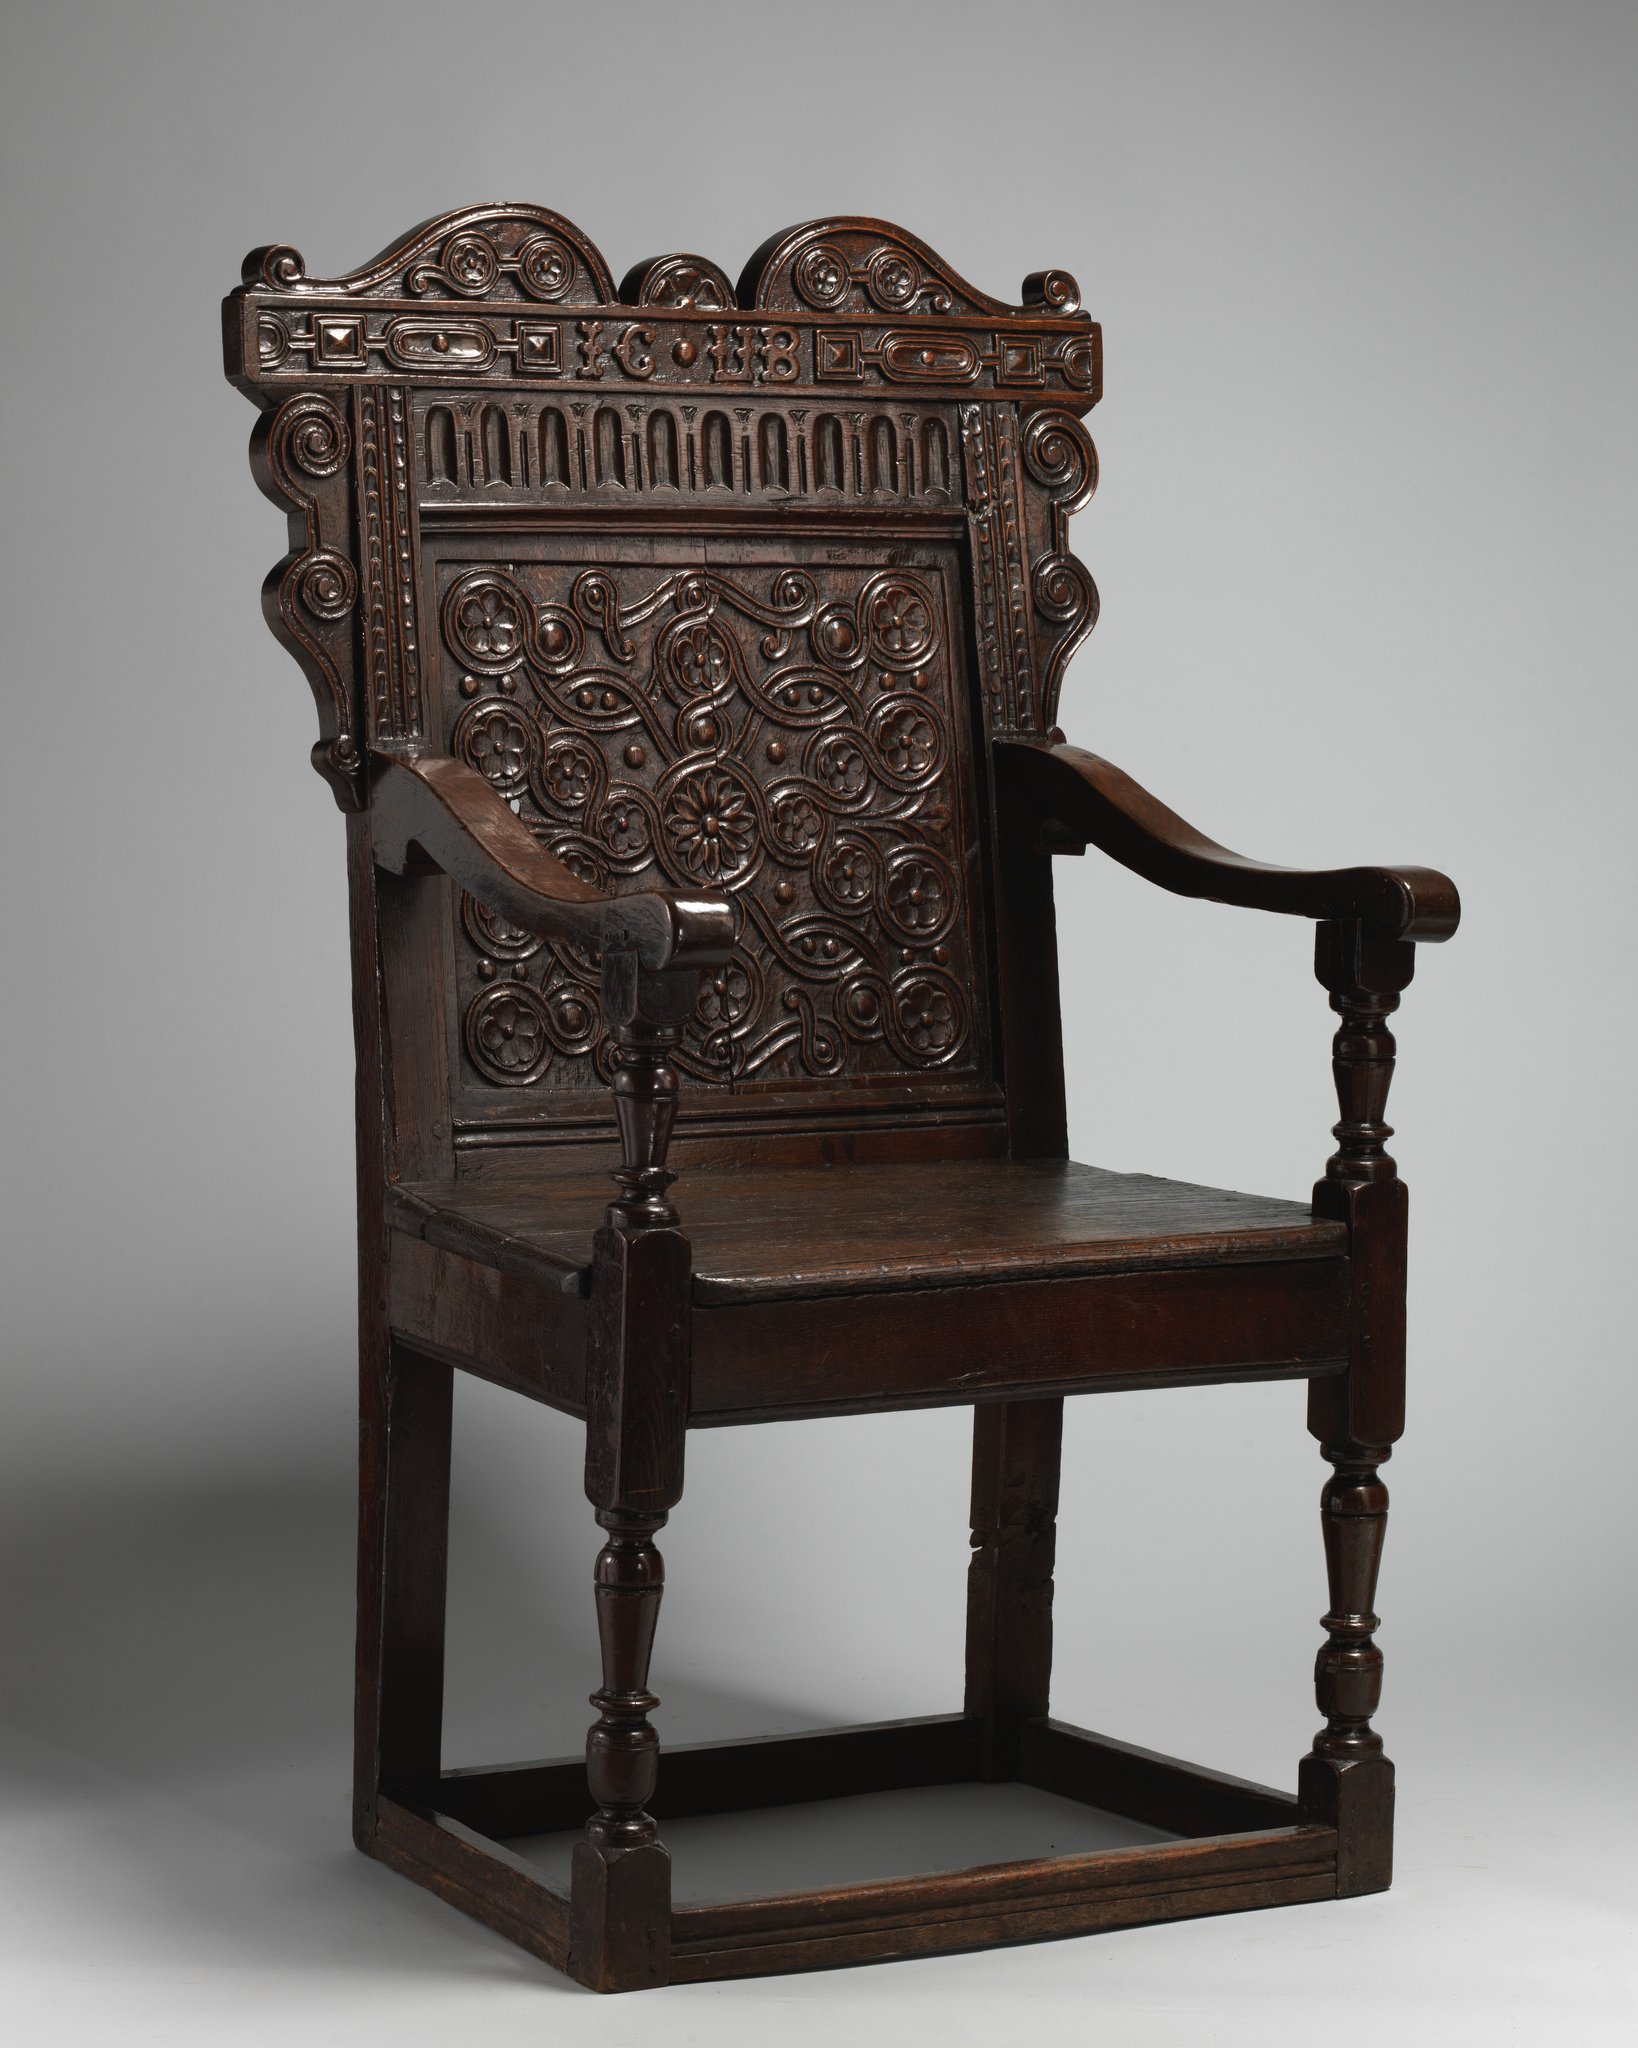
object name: armchair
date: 1601-1700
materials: wood